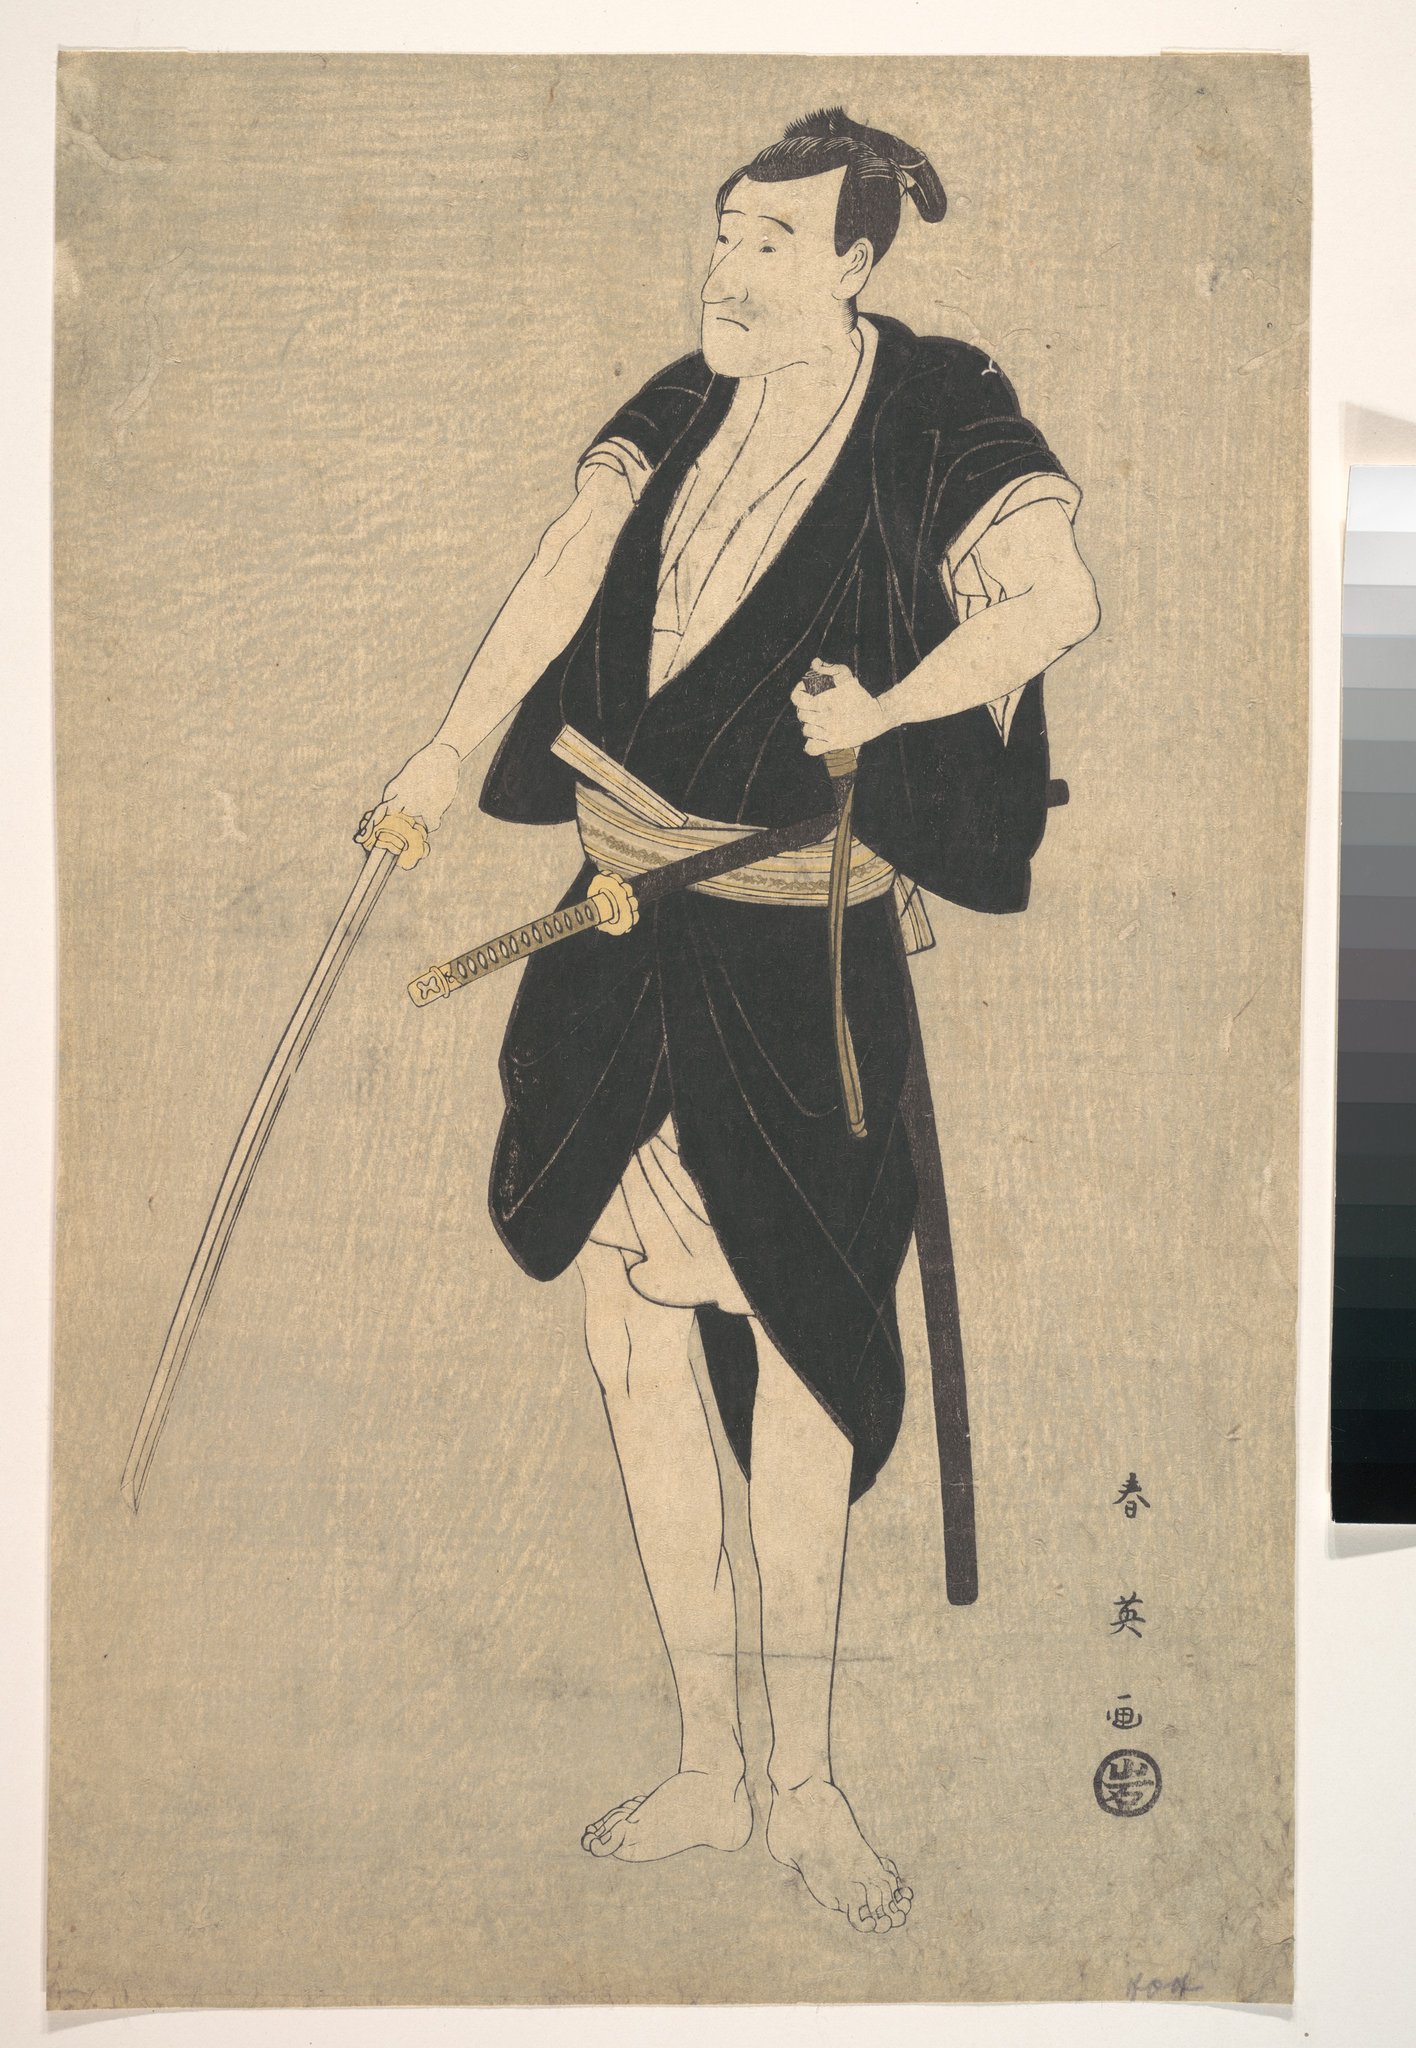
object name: print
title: An Actor as Sadakuro in the Forty–seven Ronins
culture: japanese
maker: katsukawa shun'ei 勝川春英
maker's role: artist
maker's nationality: japanese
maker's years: 1762-1819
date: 1762-1819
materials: ink, paper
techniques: woodblock print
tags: swords,men,actors